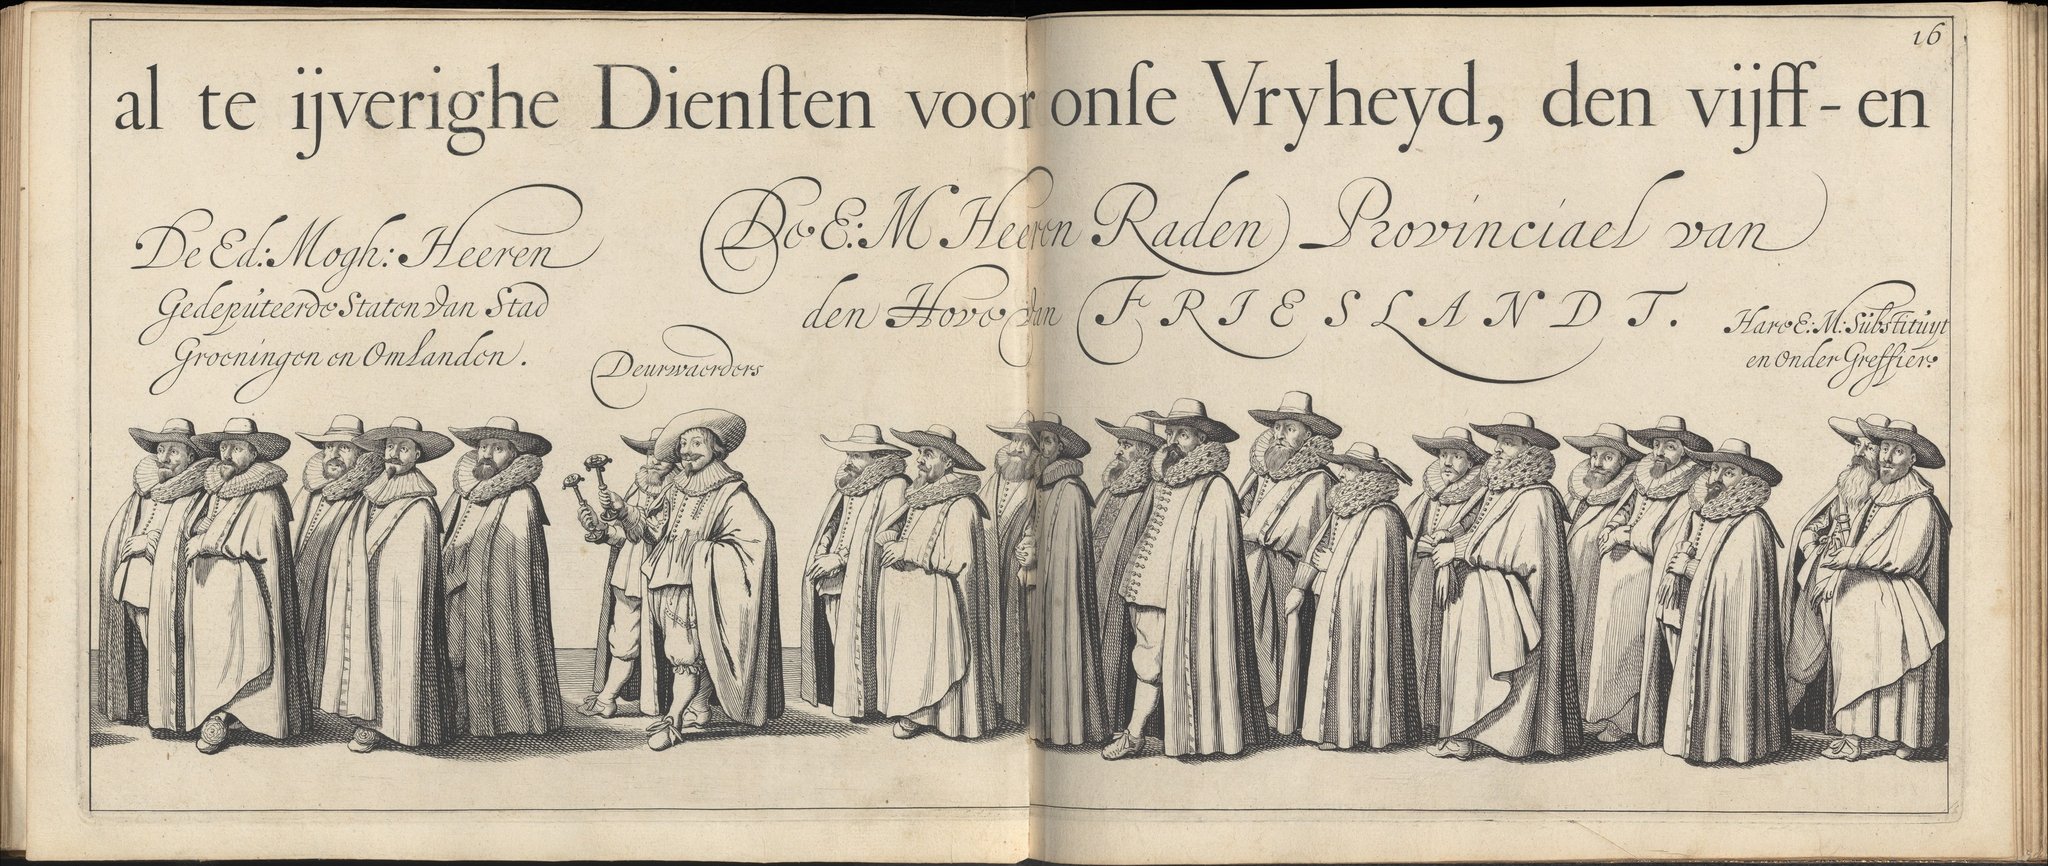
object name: book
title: The Funeral Procession of Count Ernst Casimir, Stadtholder of Friesland and Groningen, that took place in Leeuwarden on January 3, 1633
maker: jan herman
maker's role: artist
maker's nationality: dutch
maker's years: 1600-1650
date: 1634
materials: leather, gilt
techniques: bookbinding, engraving, etching, inlay, letterpress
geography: netherlands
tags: men